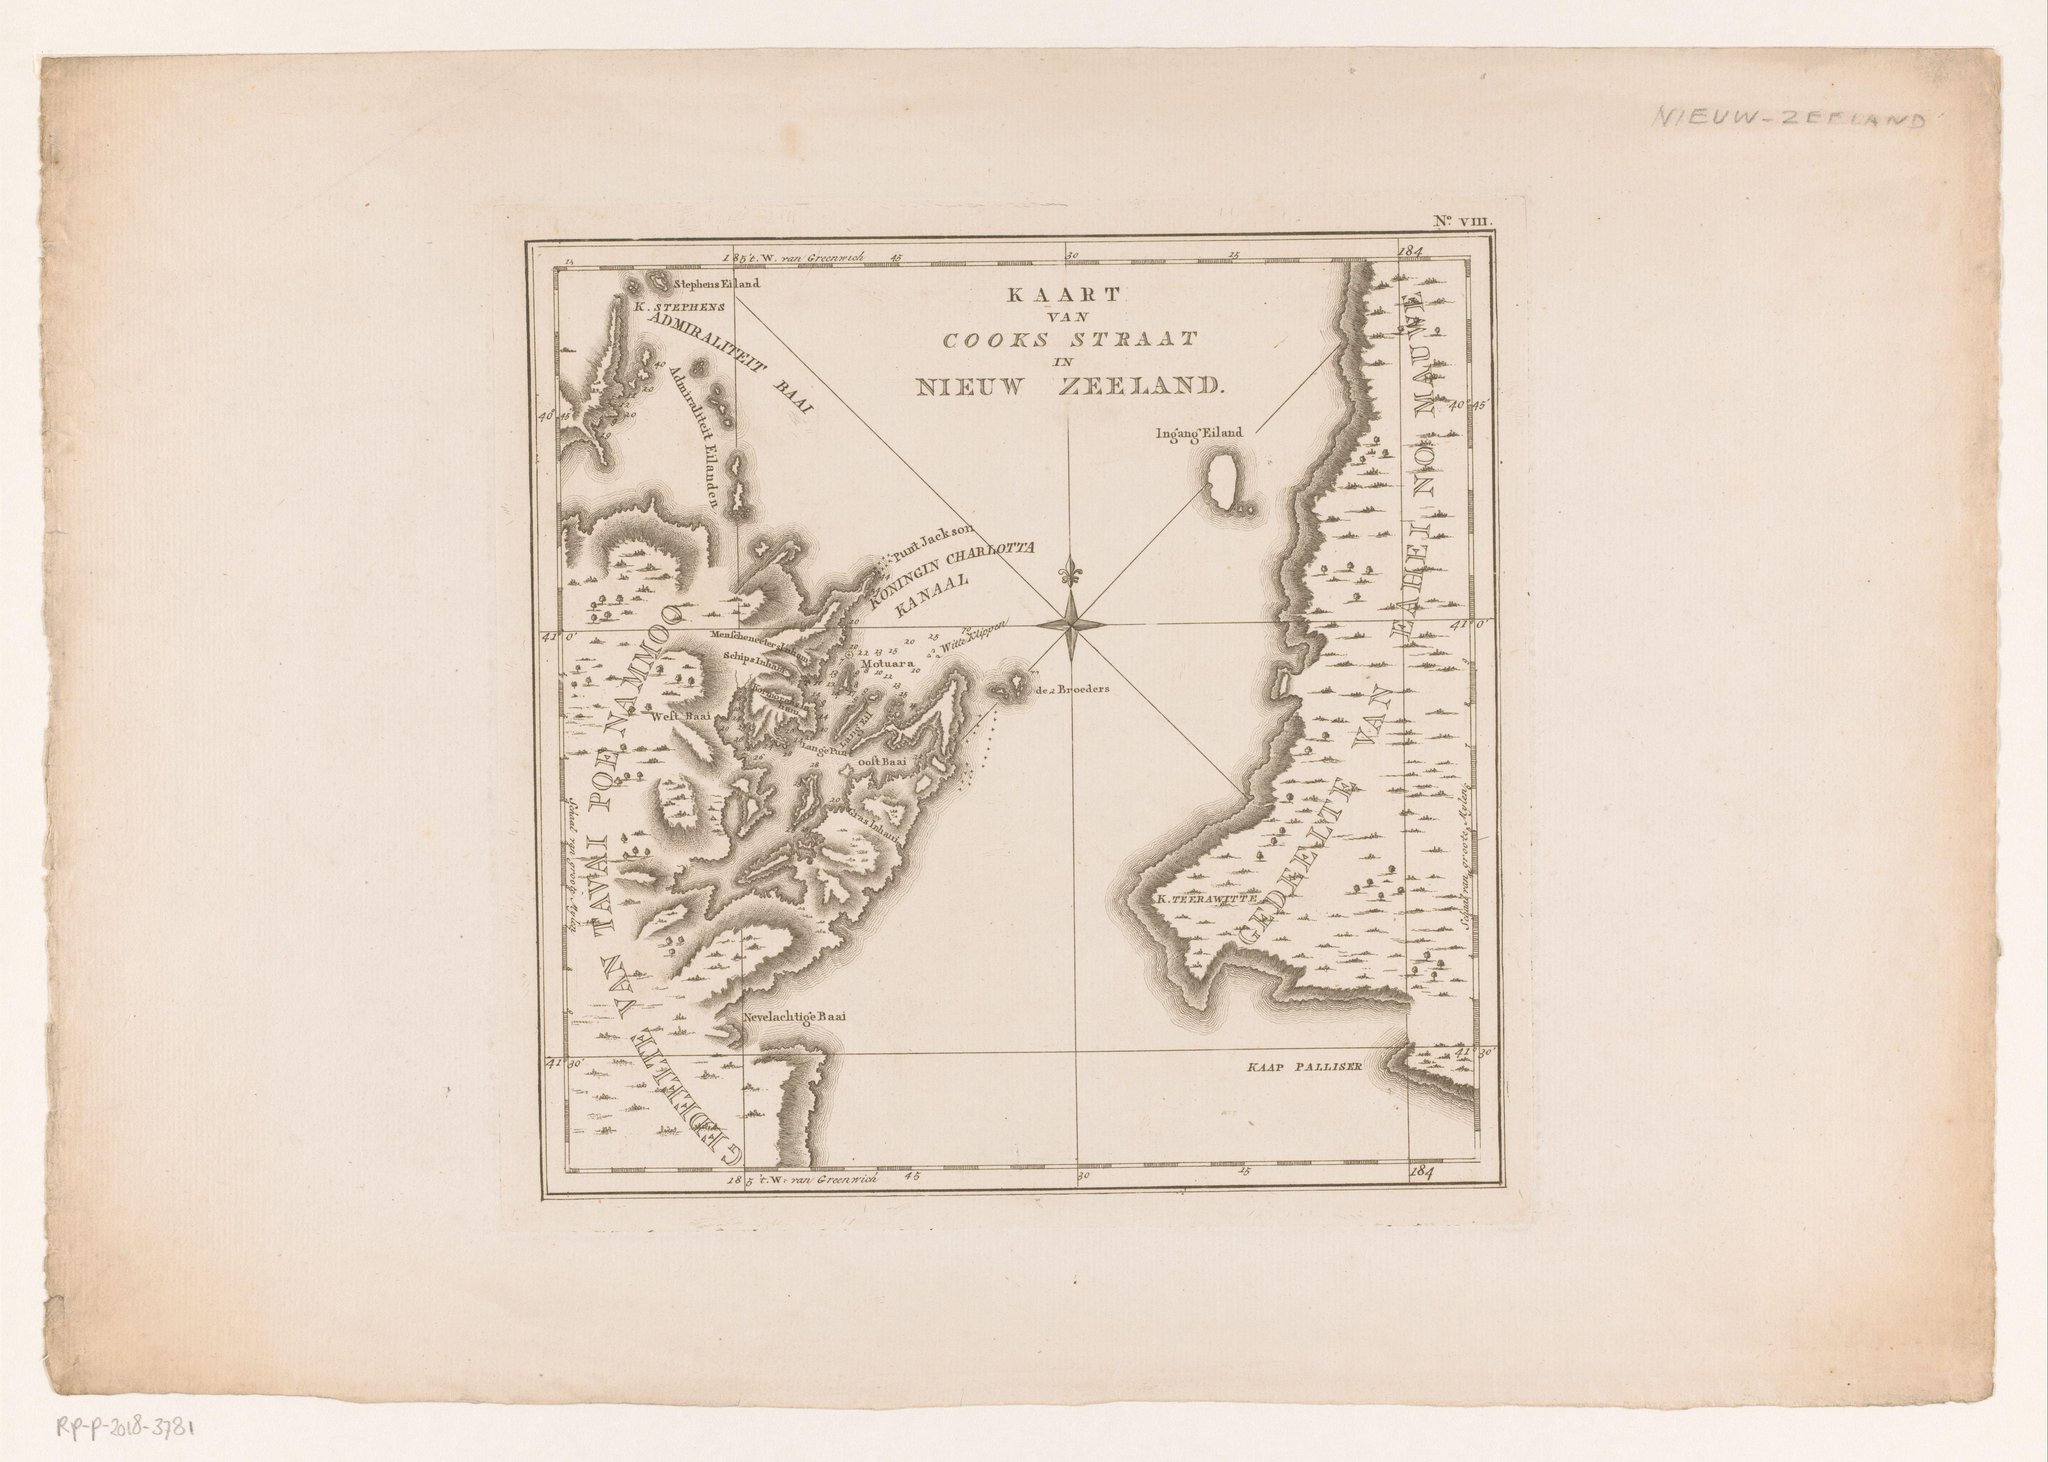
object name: print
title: Kaart van de Straat Cook in Nieuw-Zeeland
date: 1797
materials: paper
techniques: etching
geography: amsterdam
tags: maps, atlases, new zealand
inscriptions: collector's mark: Lugt 2228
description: Prent uit: Cook, James. Reize rondom de Waereld (...) met kaarten en plaaten. [Vertaald uit het Engels door] Jan David Pasteur. Leiden: Honkoop, Amsterdam: Allart, Den Haag: Van Cleef, 1797, dl. 2, p. 209.